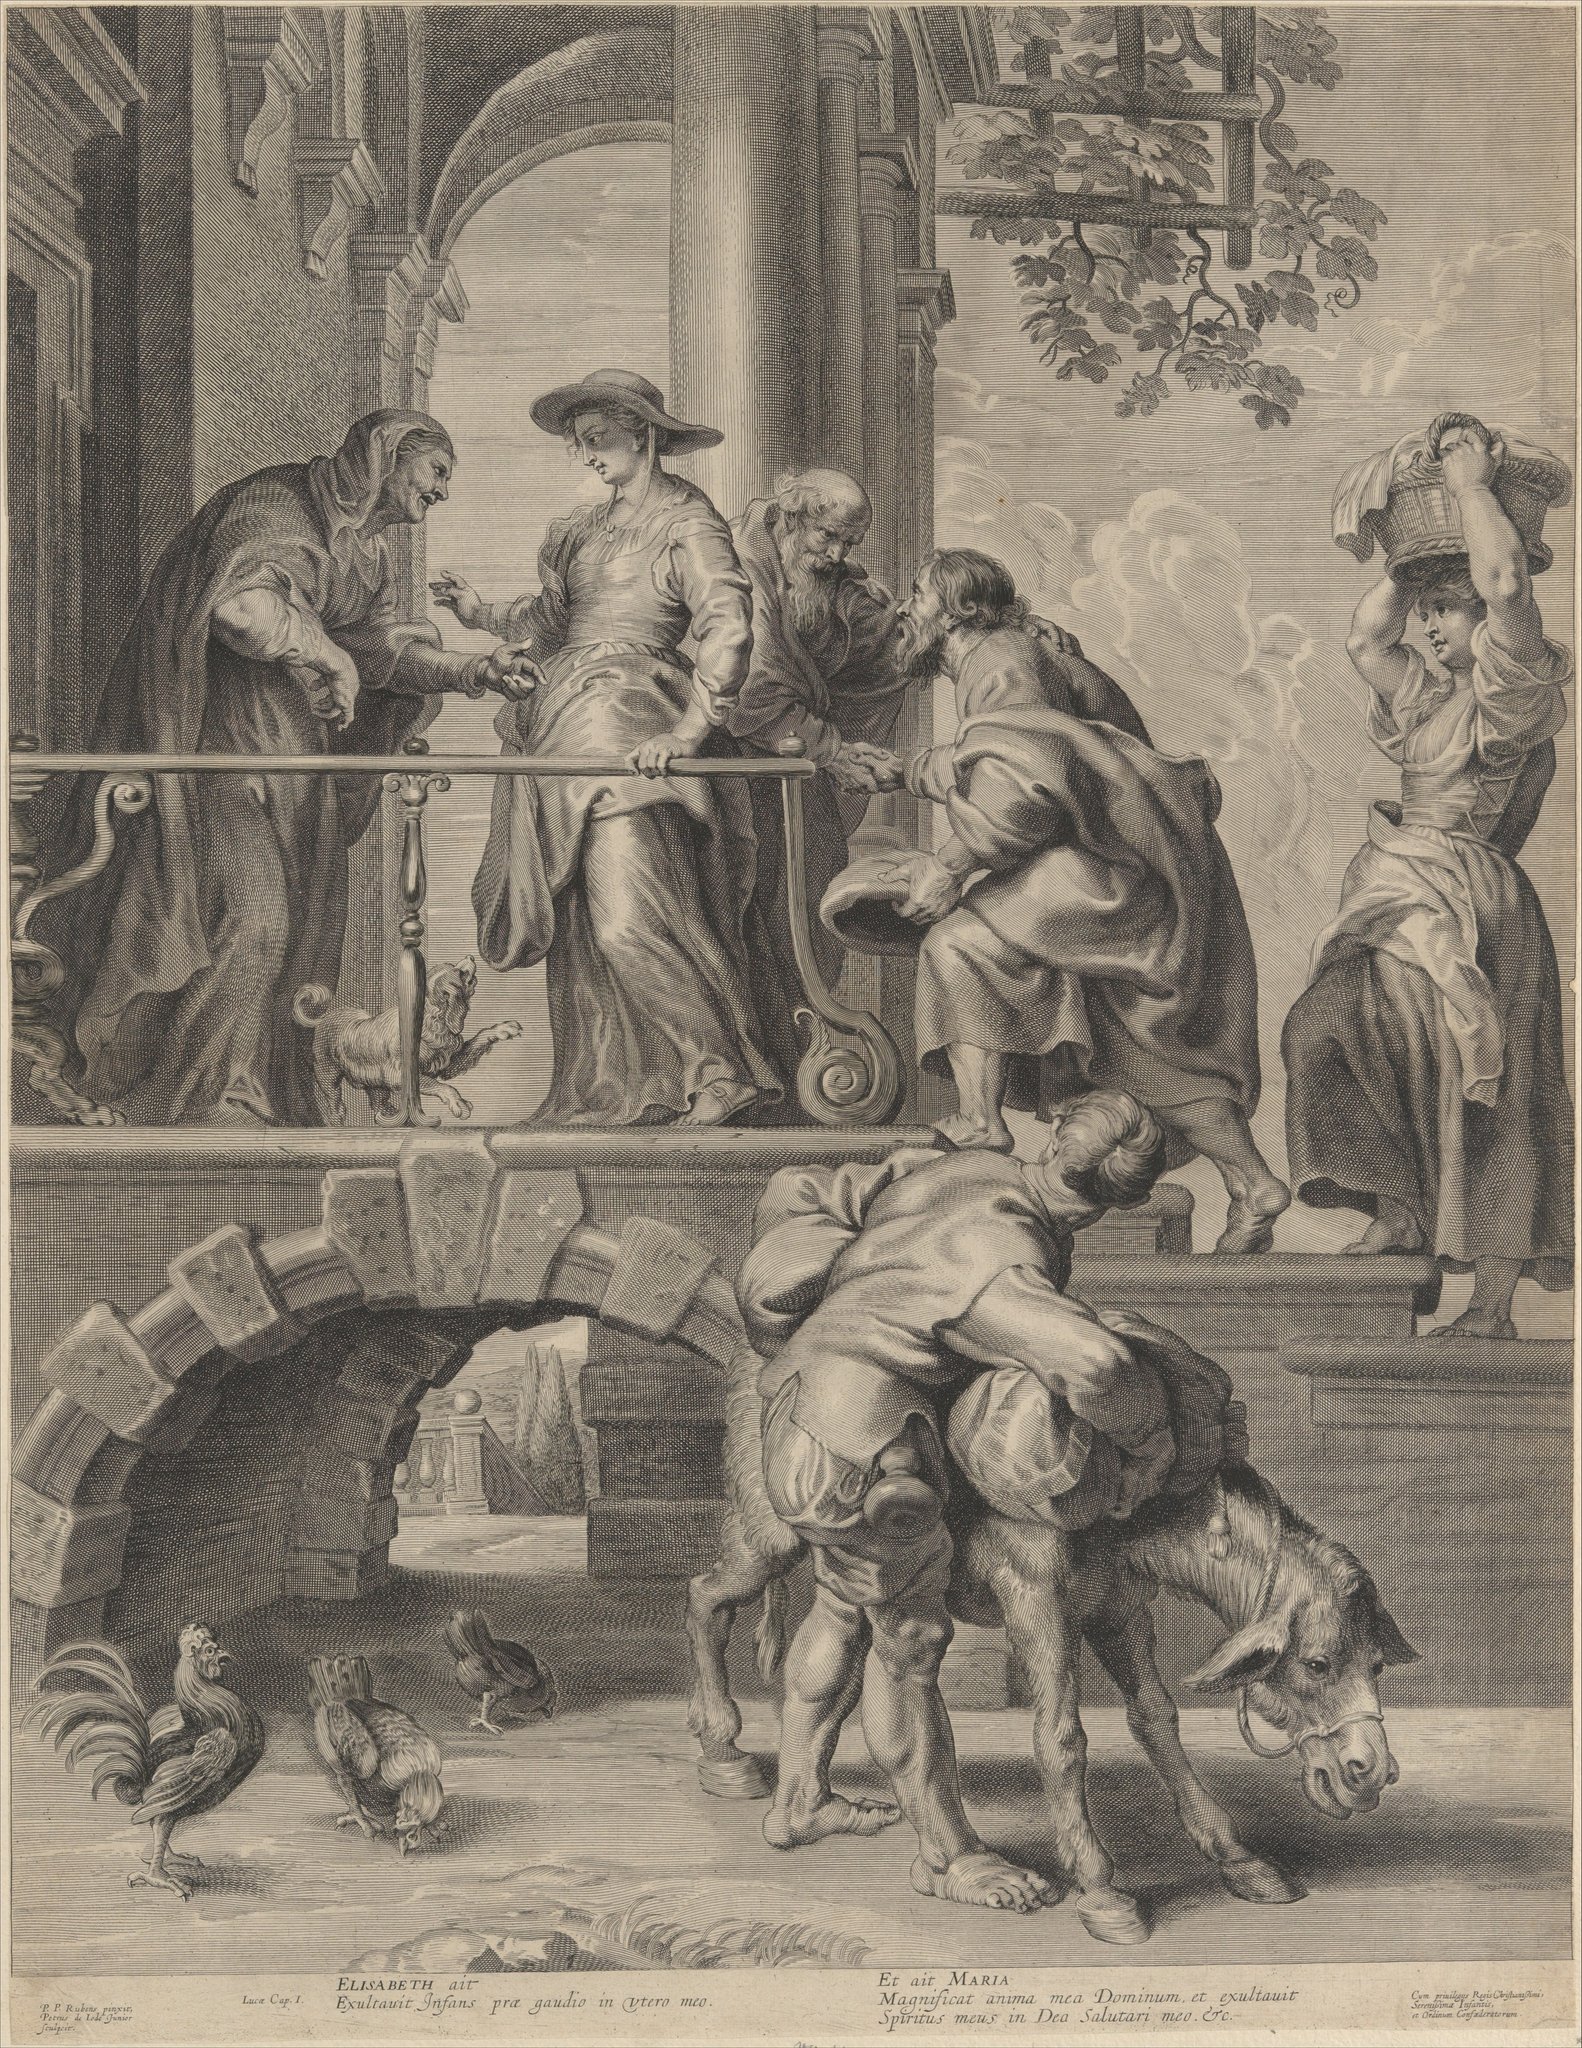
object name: print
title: The Visitation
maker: pieter de jode (ii)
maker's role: artist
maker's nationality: flemish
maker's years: 1606-1674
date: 1625-1674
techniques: engraving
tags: chickens,men,women,donkeys,virgin mary,visitation